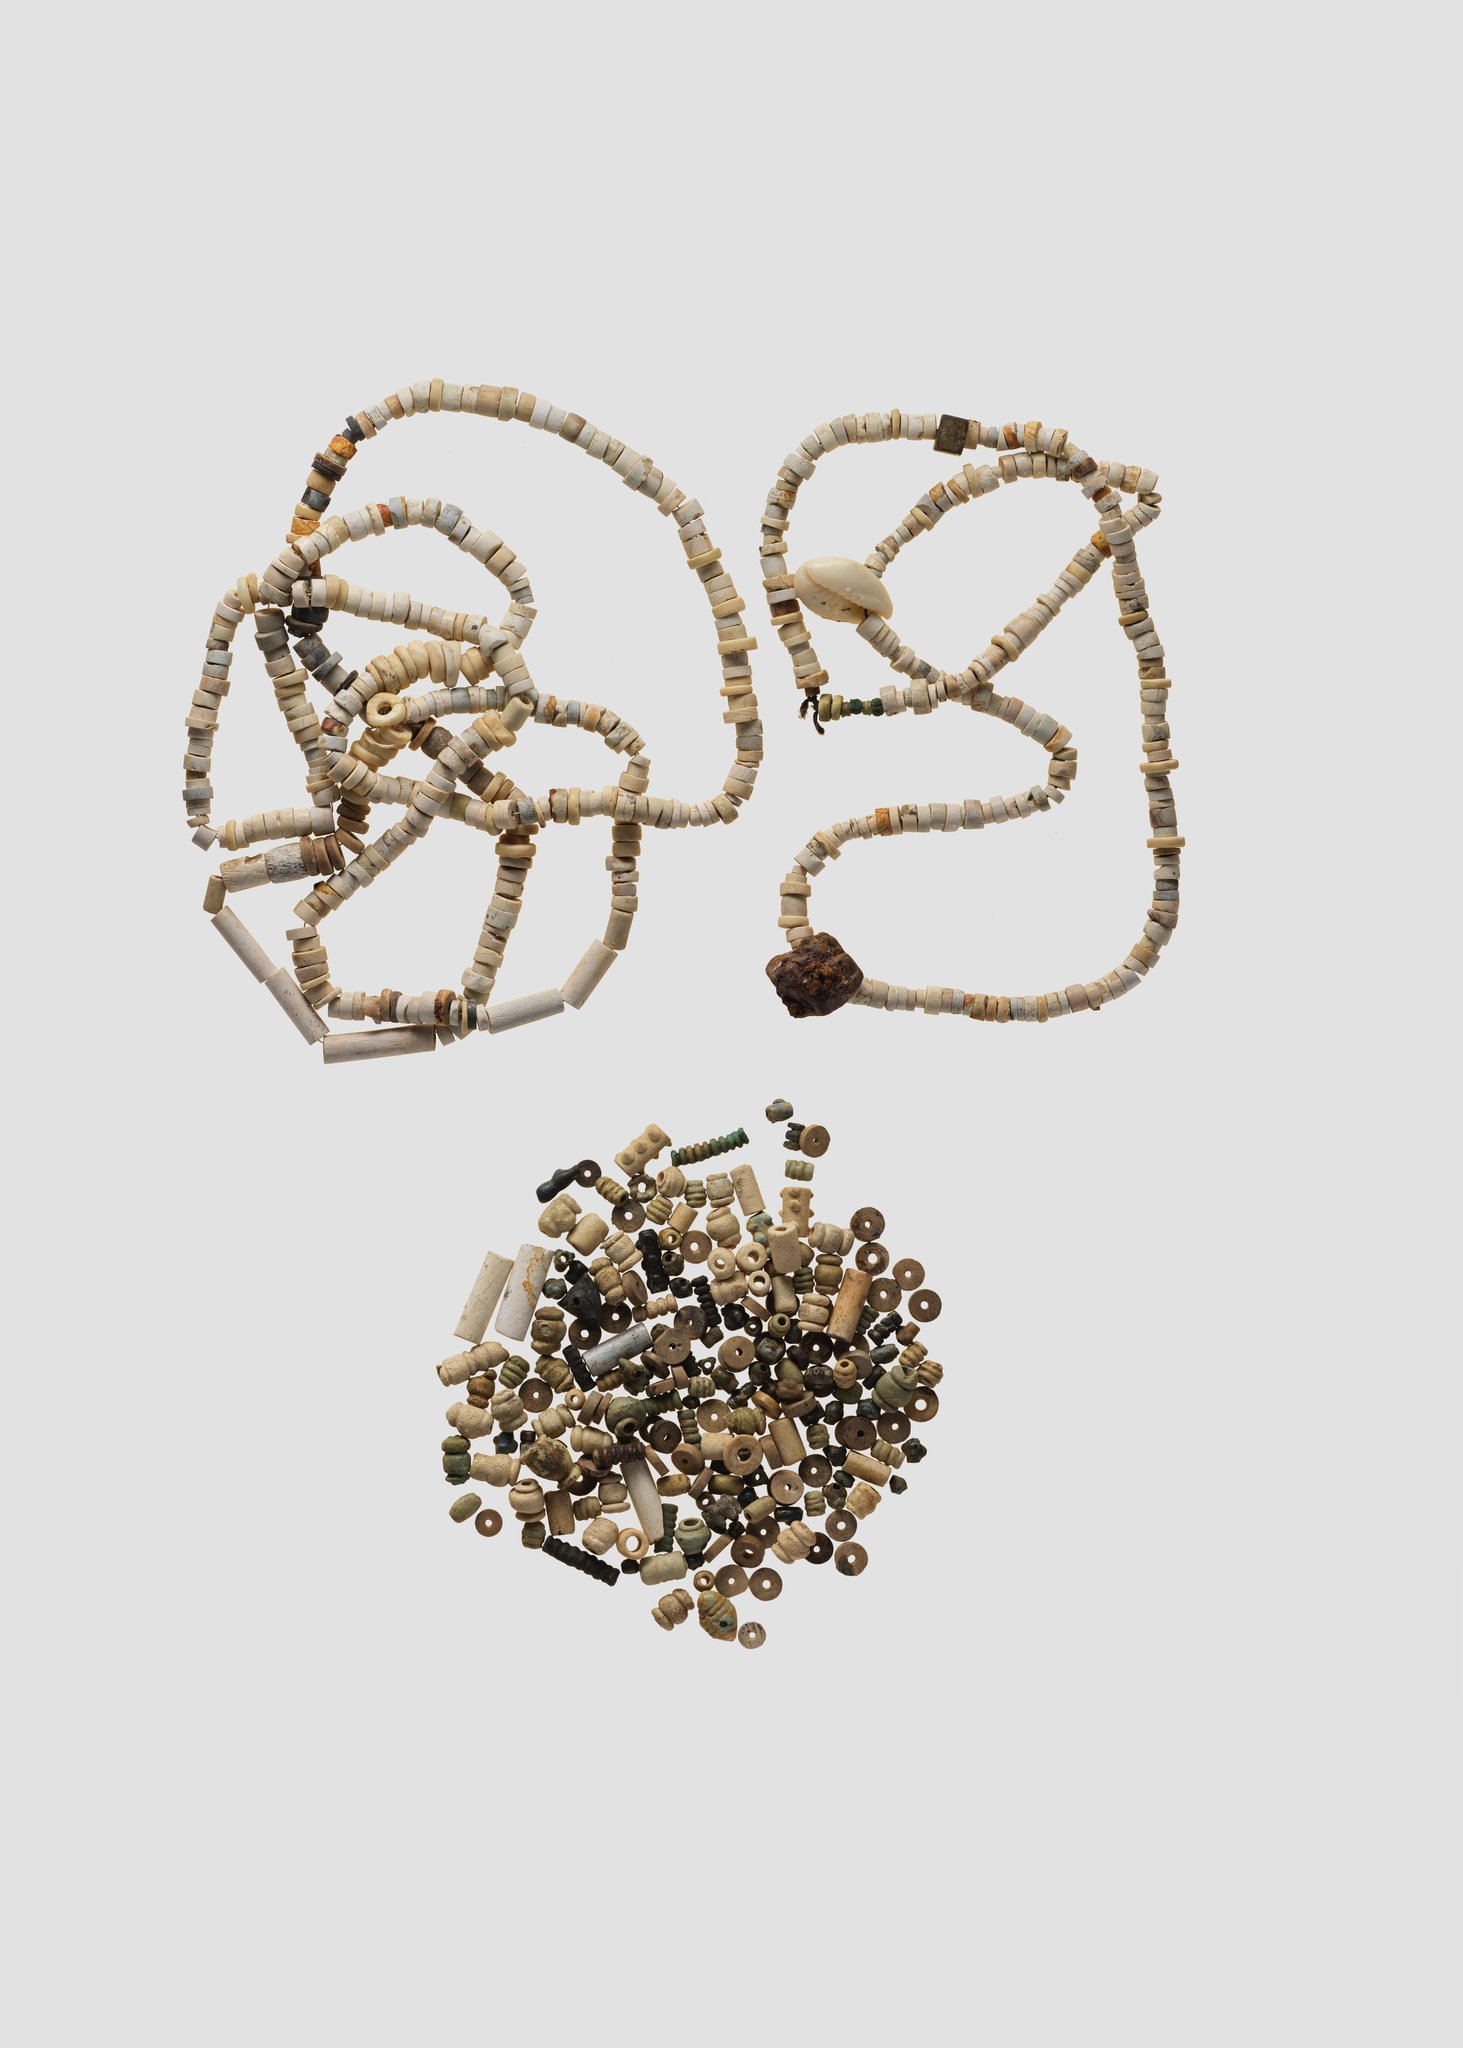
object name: bead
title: Necklace of three strands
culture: iranian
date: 900-801 BCE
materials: glass, shell, stone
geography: iran